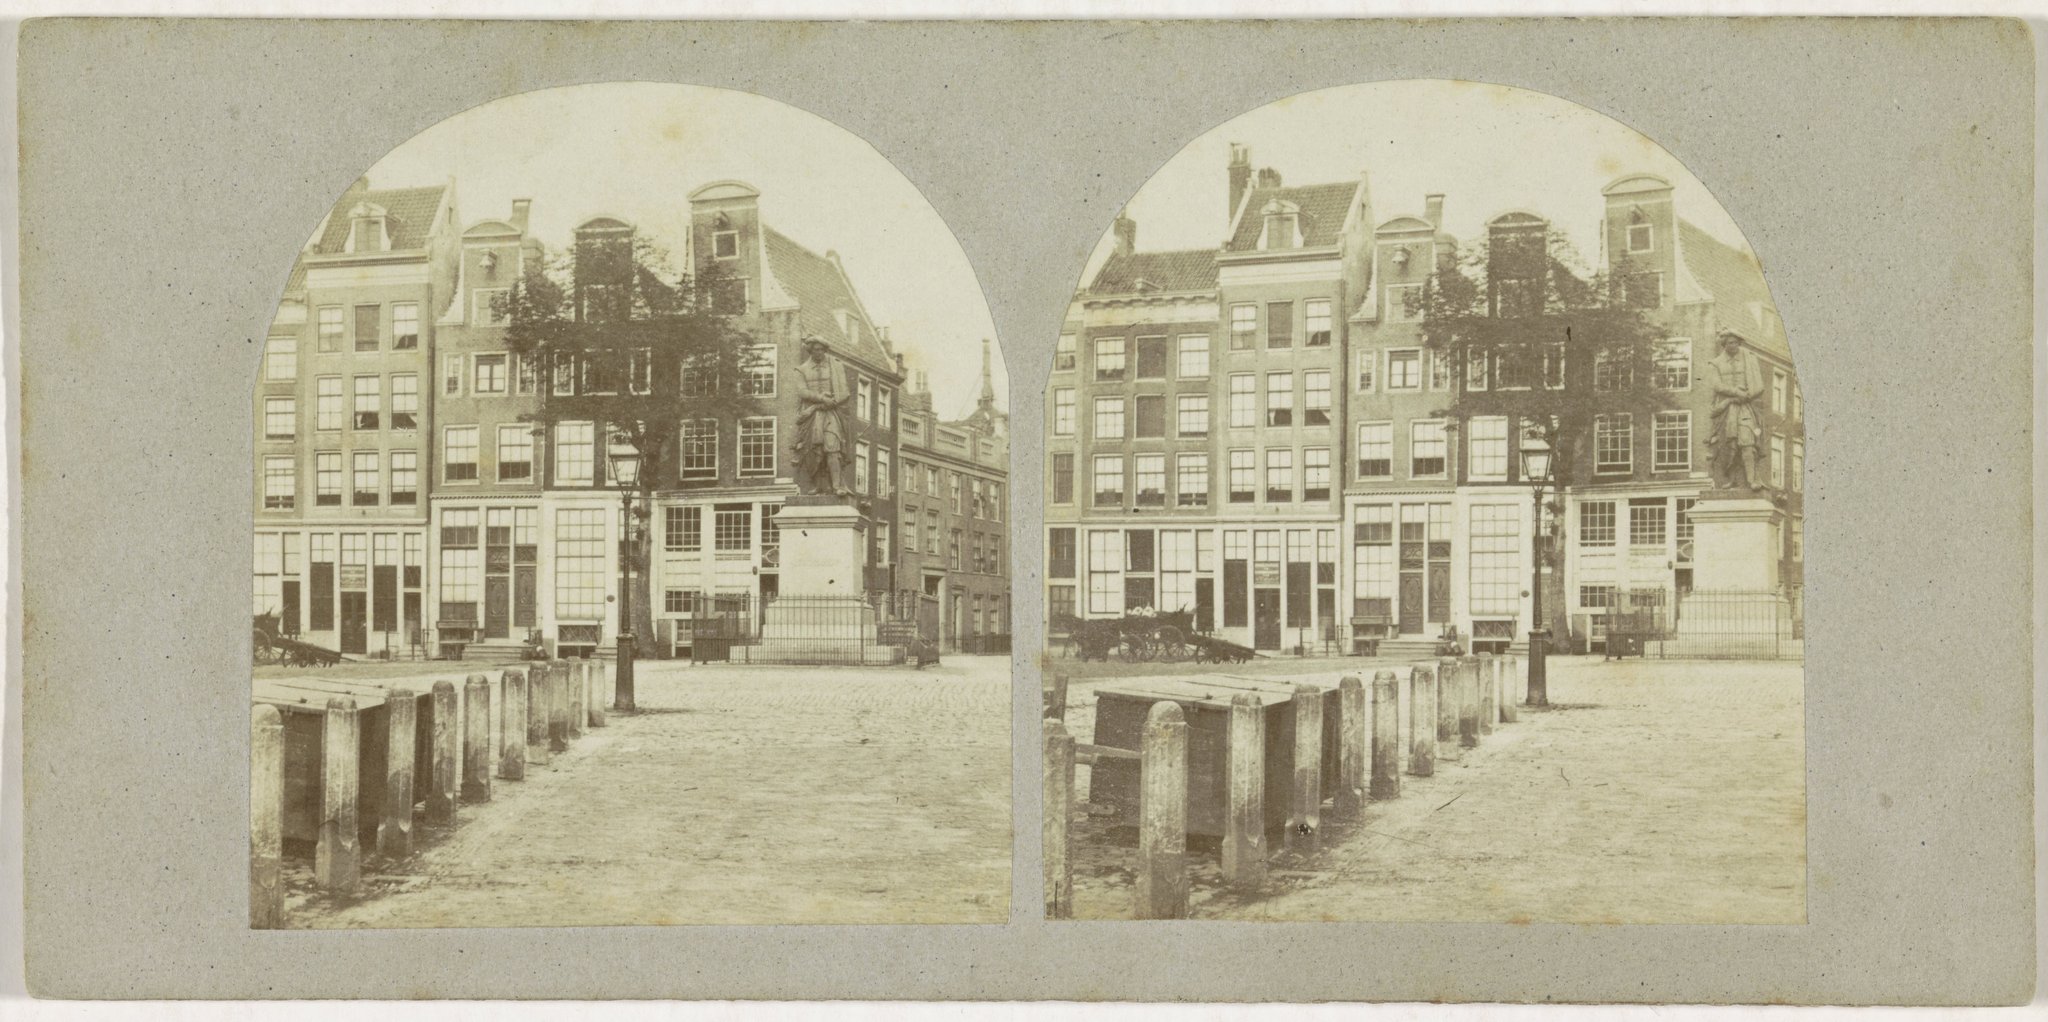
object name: photograph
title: Rembrandtplein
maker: Anonymous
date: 1856-1922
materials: cardboard, paper, photographic support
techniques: albumen print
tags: amsterdam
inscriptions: annotation: ‘GB’, inscription: ‘II’, annotation: ‘Rembrantsplein Amsterdam Nº 58.’